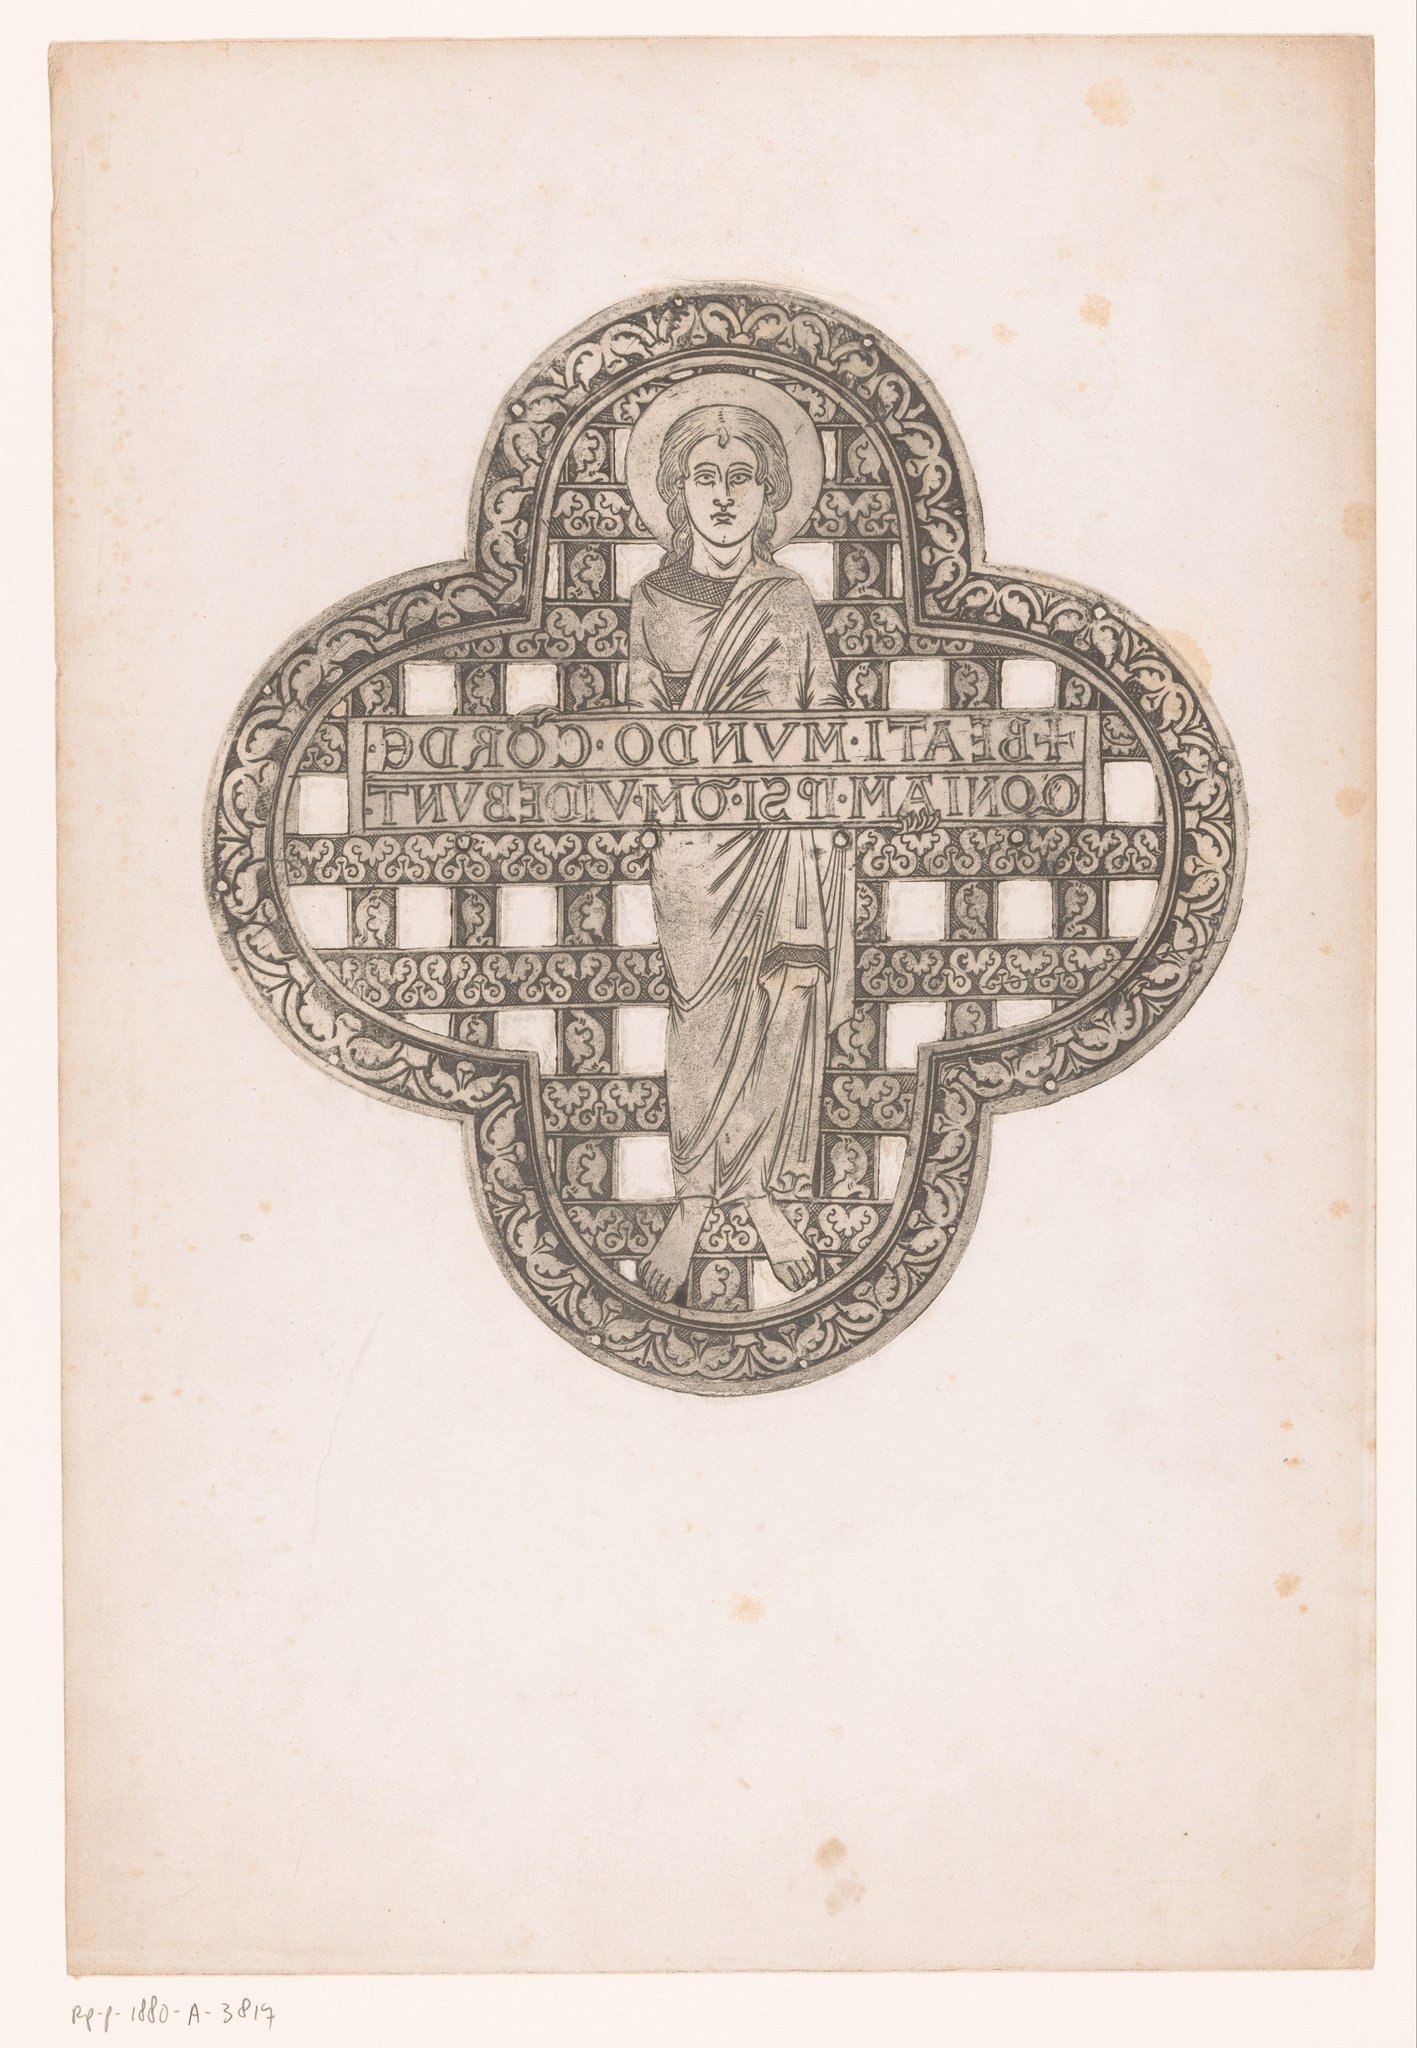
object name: print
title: Deel van de kroon van Karel de Grote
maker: Anonymous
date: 1850-1880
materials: paper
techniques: etching, intaglio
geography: germany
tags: crown (symbol of sovereignty)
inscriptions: collector's mark: Lugt 2228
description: Onderdeel van een serie van zestien prenten naar de platen van de kroon van Karel de Grote. De koperplaat is geperforeerd om het origineel te imiteren.